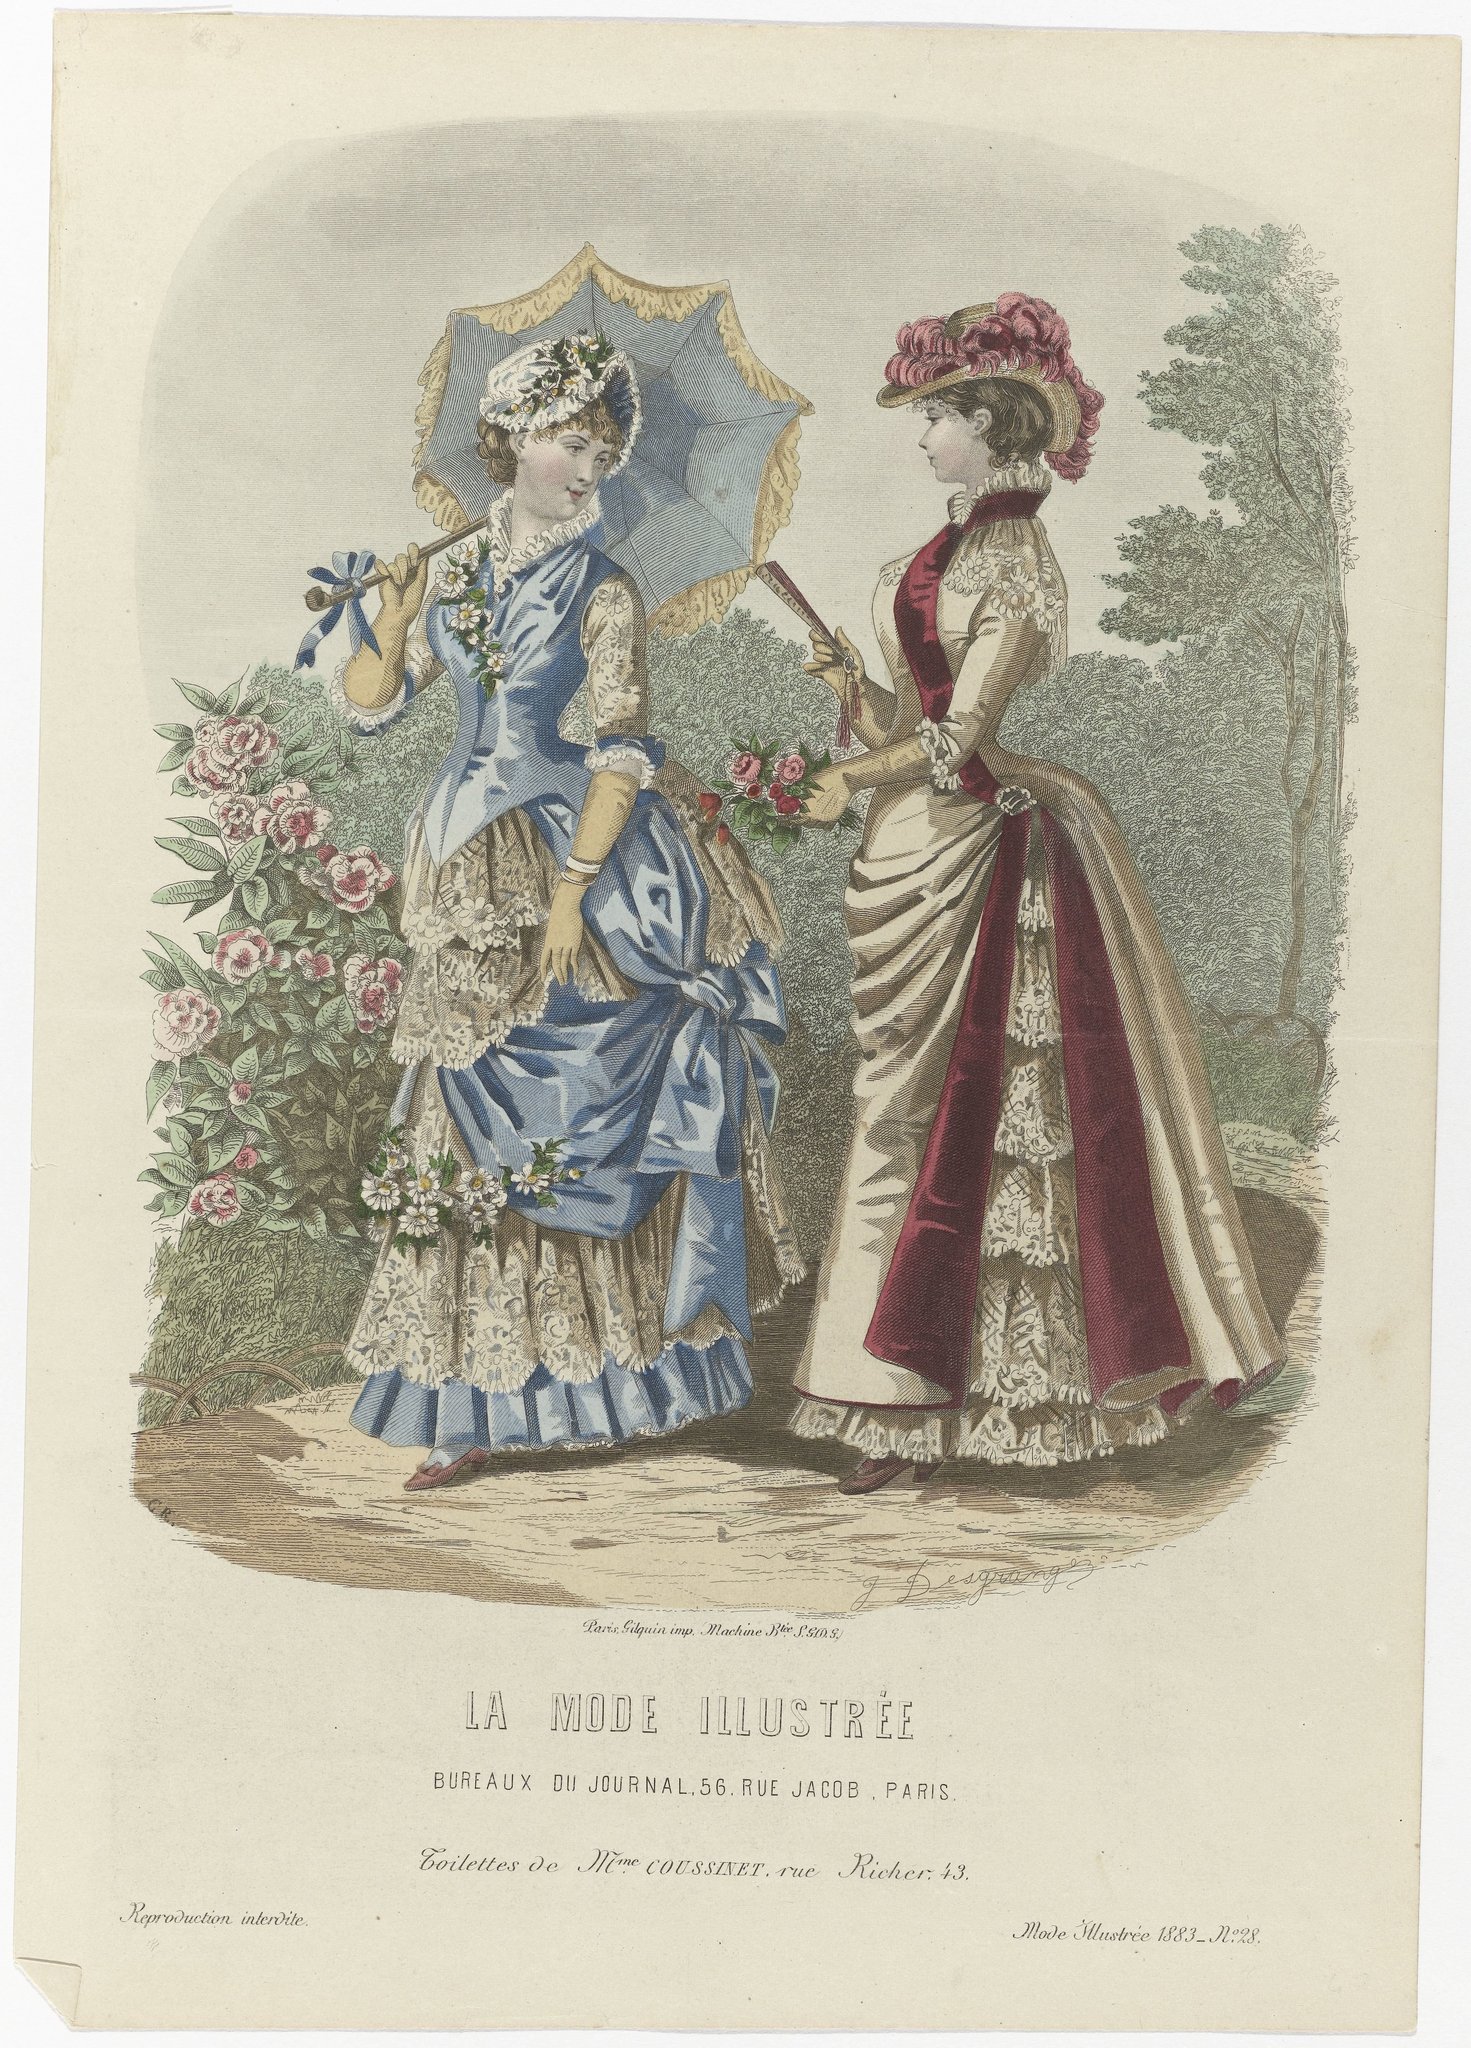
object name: fashion print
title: La Mode Illustrée, 1883, No. 28 : Toilettes de Mme Coussinet (...)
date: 1883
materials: paper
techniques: engraving, hand coloring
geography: paris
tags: cut flowers; nosegay, bunch of flowers, fashion plates, head-gear: hat (+ women's clothes), shoes, sandals (+ women's clothes), gloves, mittens, etc. (+ women's clothes), dress, gown (+ women's clothes), fan (+ women's clothes), bracelet, wristlet (+ women's clothes)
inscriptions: address: ‘Bureaux du journal, 56, Rue Jacob Paris’, title: ‘La Mode Illustrée’, caption: ‘Toilettes de M.me Coussinet, rue Richer, 43.’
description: Twee vrouwen in japonnen met tournure van Coussinet. Prent uit het modetijdschrift La Mode Illustrée (1860-1937).